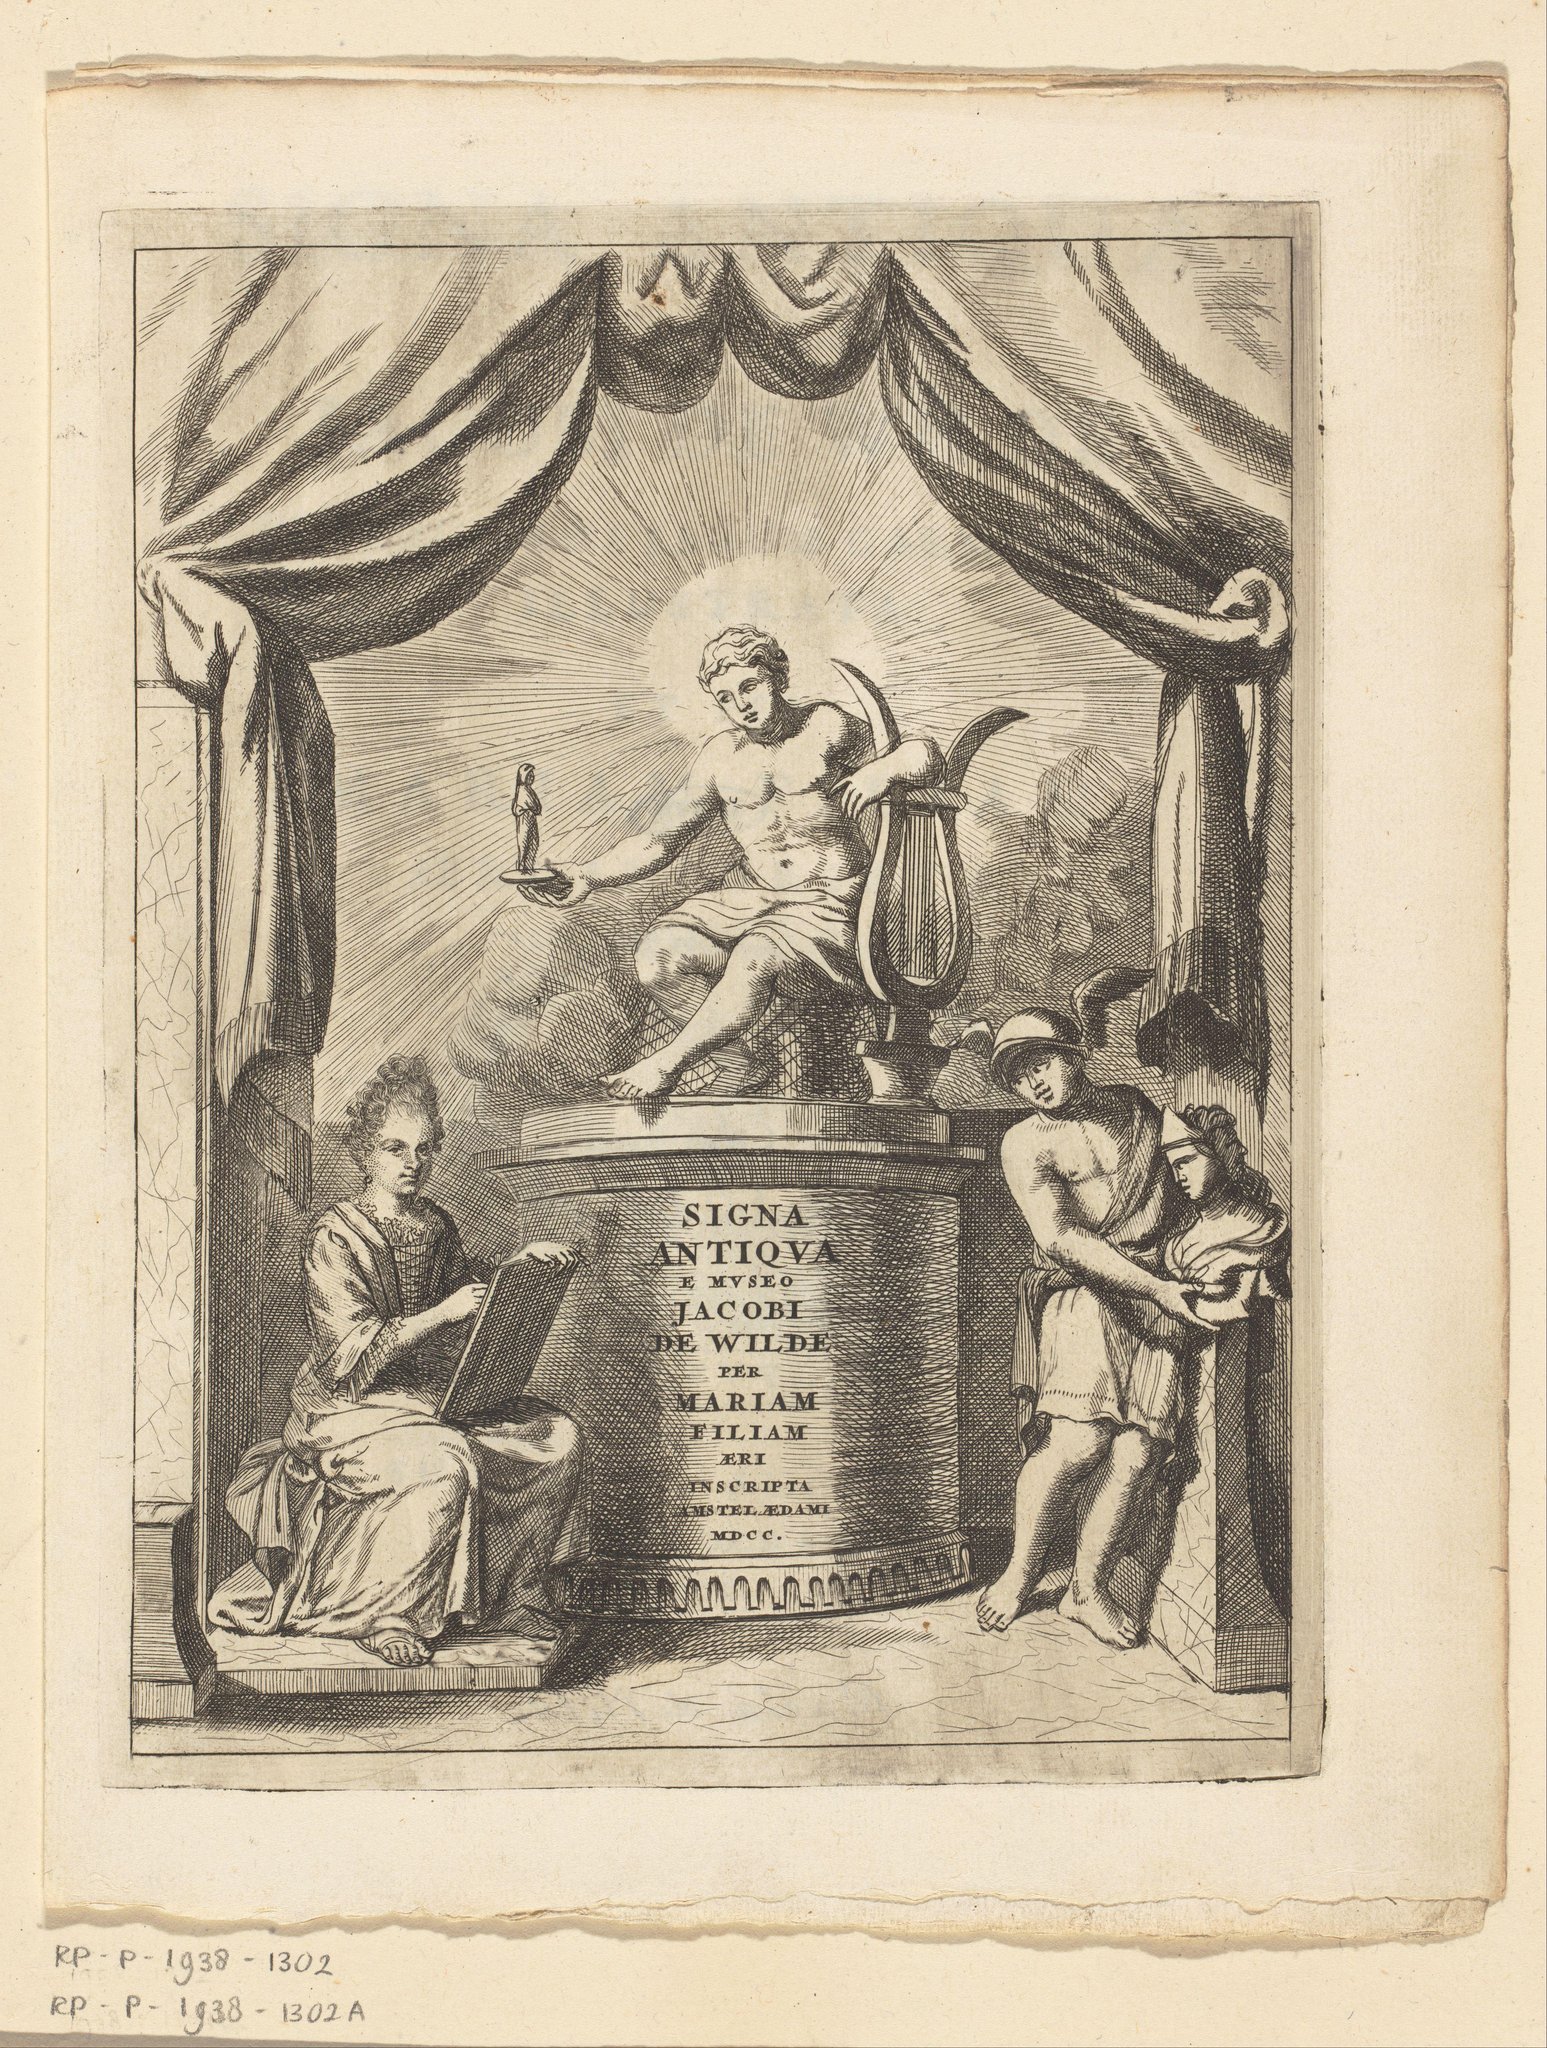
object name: titelblad, titelpagina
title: Apollo overhandigt een sculptuur aan Maria de Wilde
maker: maria de wilde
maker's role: print maker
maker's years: 1682-1775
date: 1700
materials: paper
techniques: etching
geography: amsterdam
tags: maria de wilde, title-page, piece of sculpture, reproduction of a piece of sculpture, specific aspects, allegorical aspects of mercury; mercury as patron, specific aspects, allegorical aspects of apollo; apollo as patron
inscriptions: collector's mark: Lugt 2228, collector's mark: Lugt 2760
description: Apollo troont op een zuil. Hij overhandigt een sculptuur aan Maria de Wilde, die naast de zuil zit met teken- of schrijfgerei. Rechts staat Mercurius bij een buste van een vrouw.